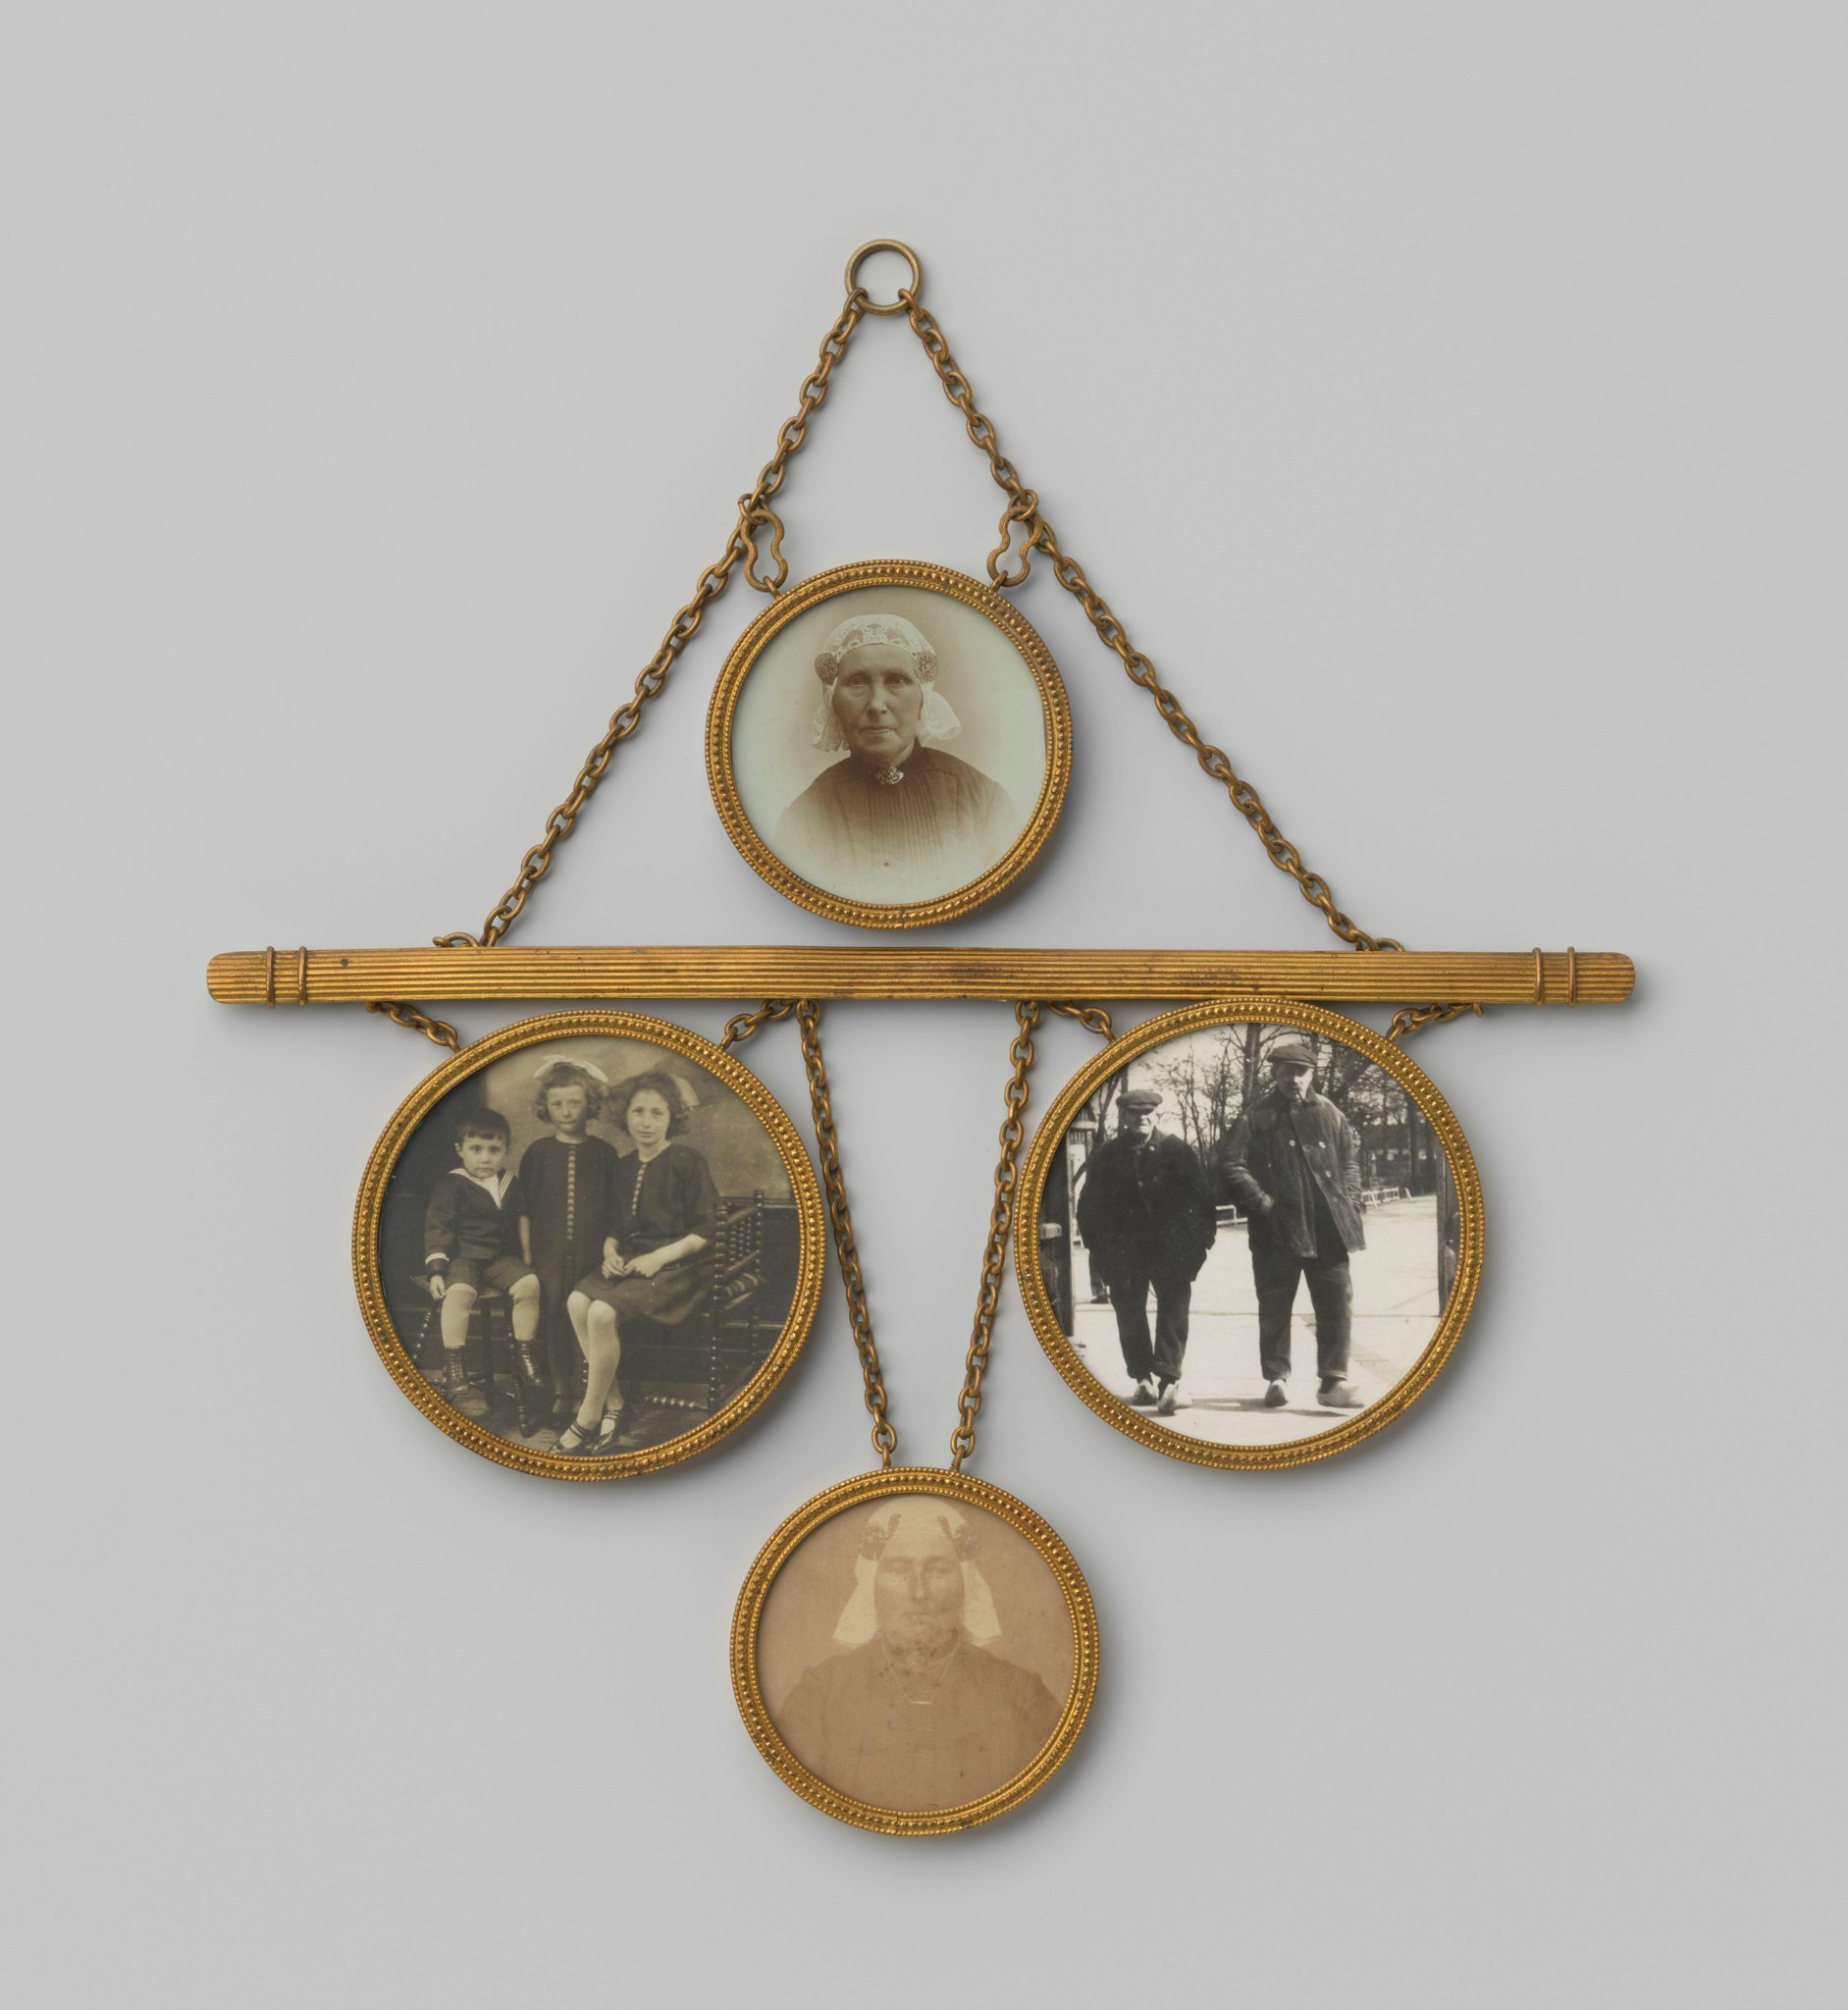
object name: photograph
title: Portret van een onbekende vrouw in klederdracht, met muts en oorijzers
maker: Anonymous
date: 1900-1930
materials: paper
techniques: albumen print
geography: netherlands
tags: adult woman, anonymous historical person portrayed, folk costume, regional costume, netherlands